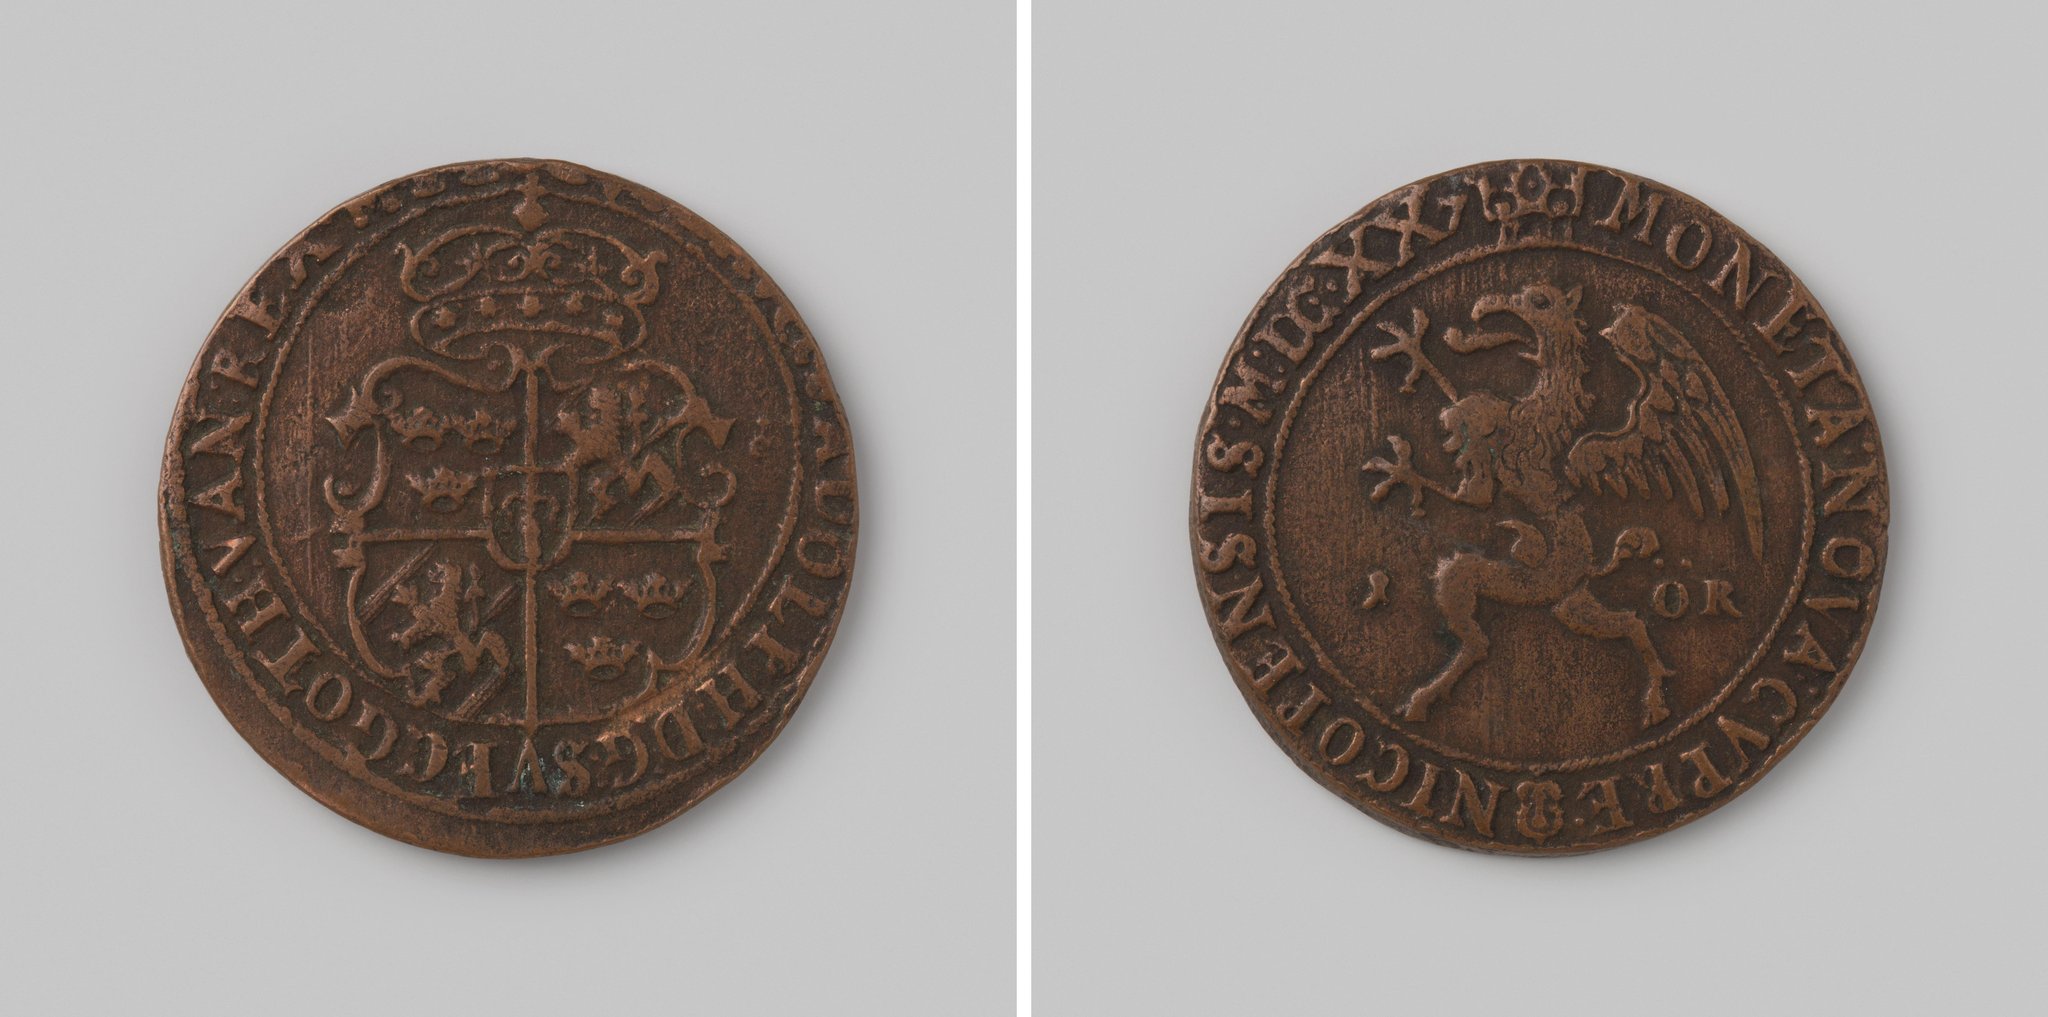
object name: coin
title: Zweden, Gustaf II Adolf, öre uit Nyköping,1627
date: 1627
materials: copper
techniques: striking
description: Koperen munt. Voorzijde: gekroond samengesteld wapenschild. Keerzijde: griffioen naar links. Waarde-aanduiding 1 ör in veld. Jaartal XX7 in omschrft. Gladde rand.